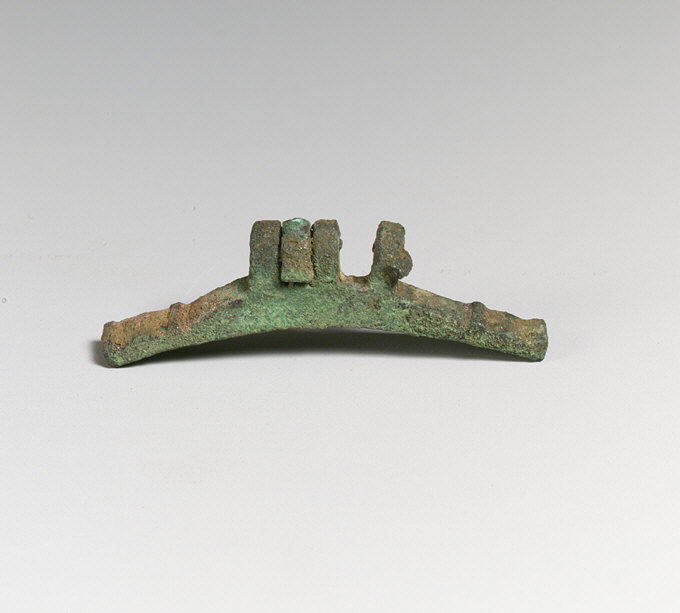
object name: hinge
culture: cypriot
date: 3900 BCE-100 CE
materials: bronze